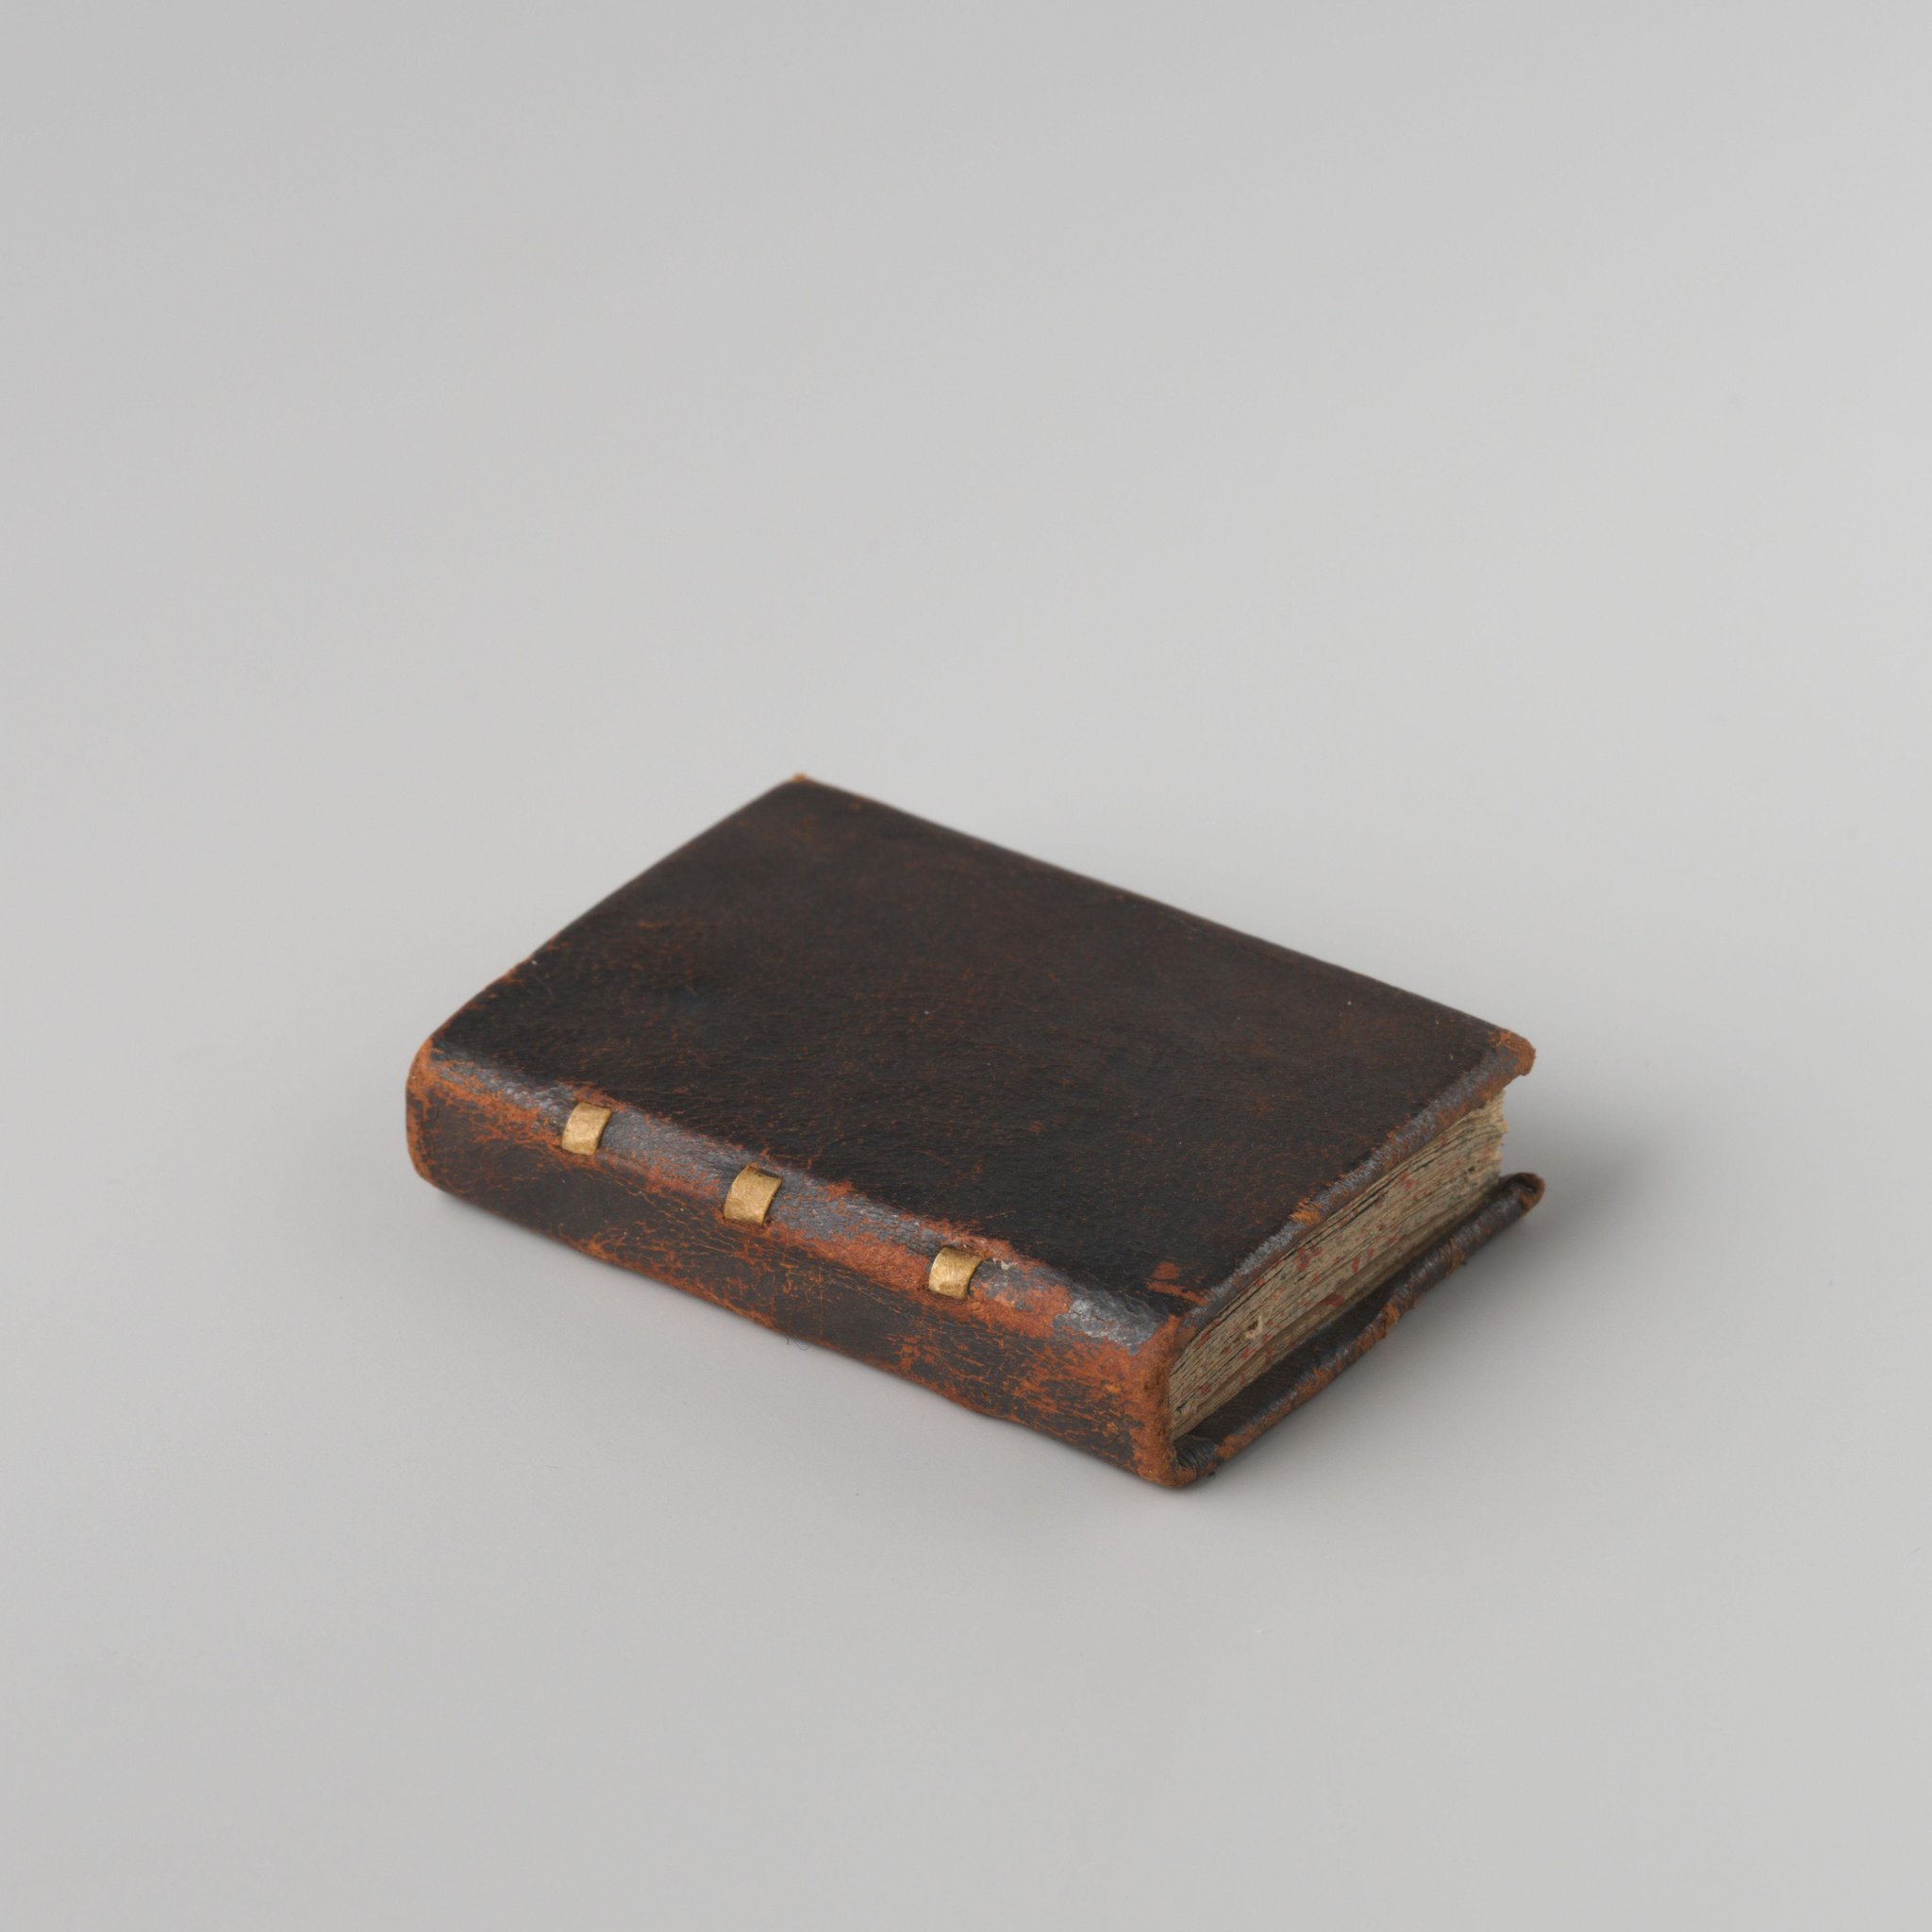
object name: miniature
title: Tuingezichten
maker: willem swidde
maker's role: print maker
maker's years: 1660-1697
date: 1690-1710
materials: leather, paper